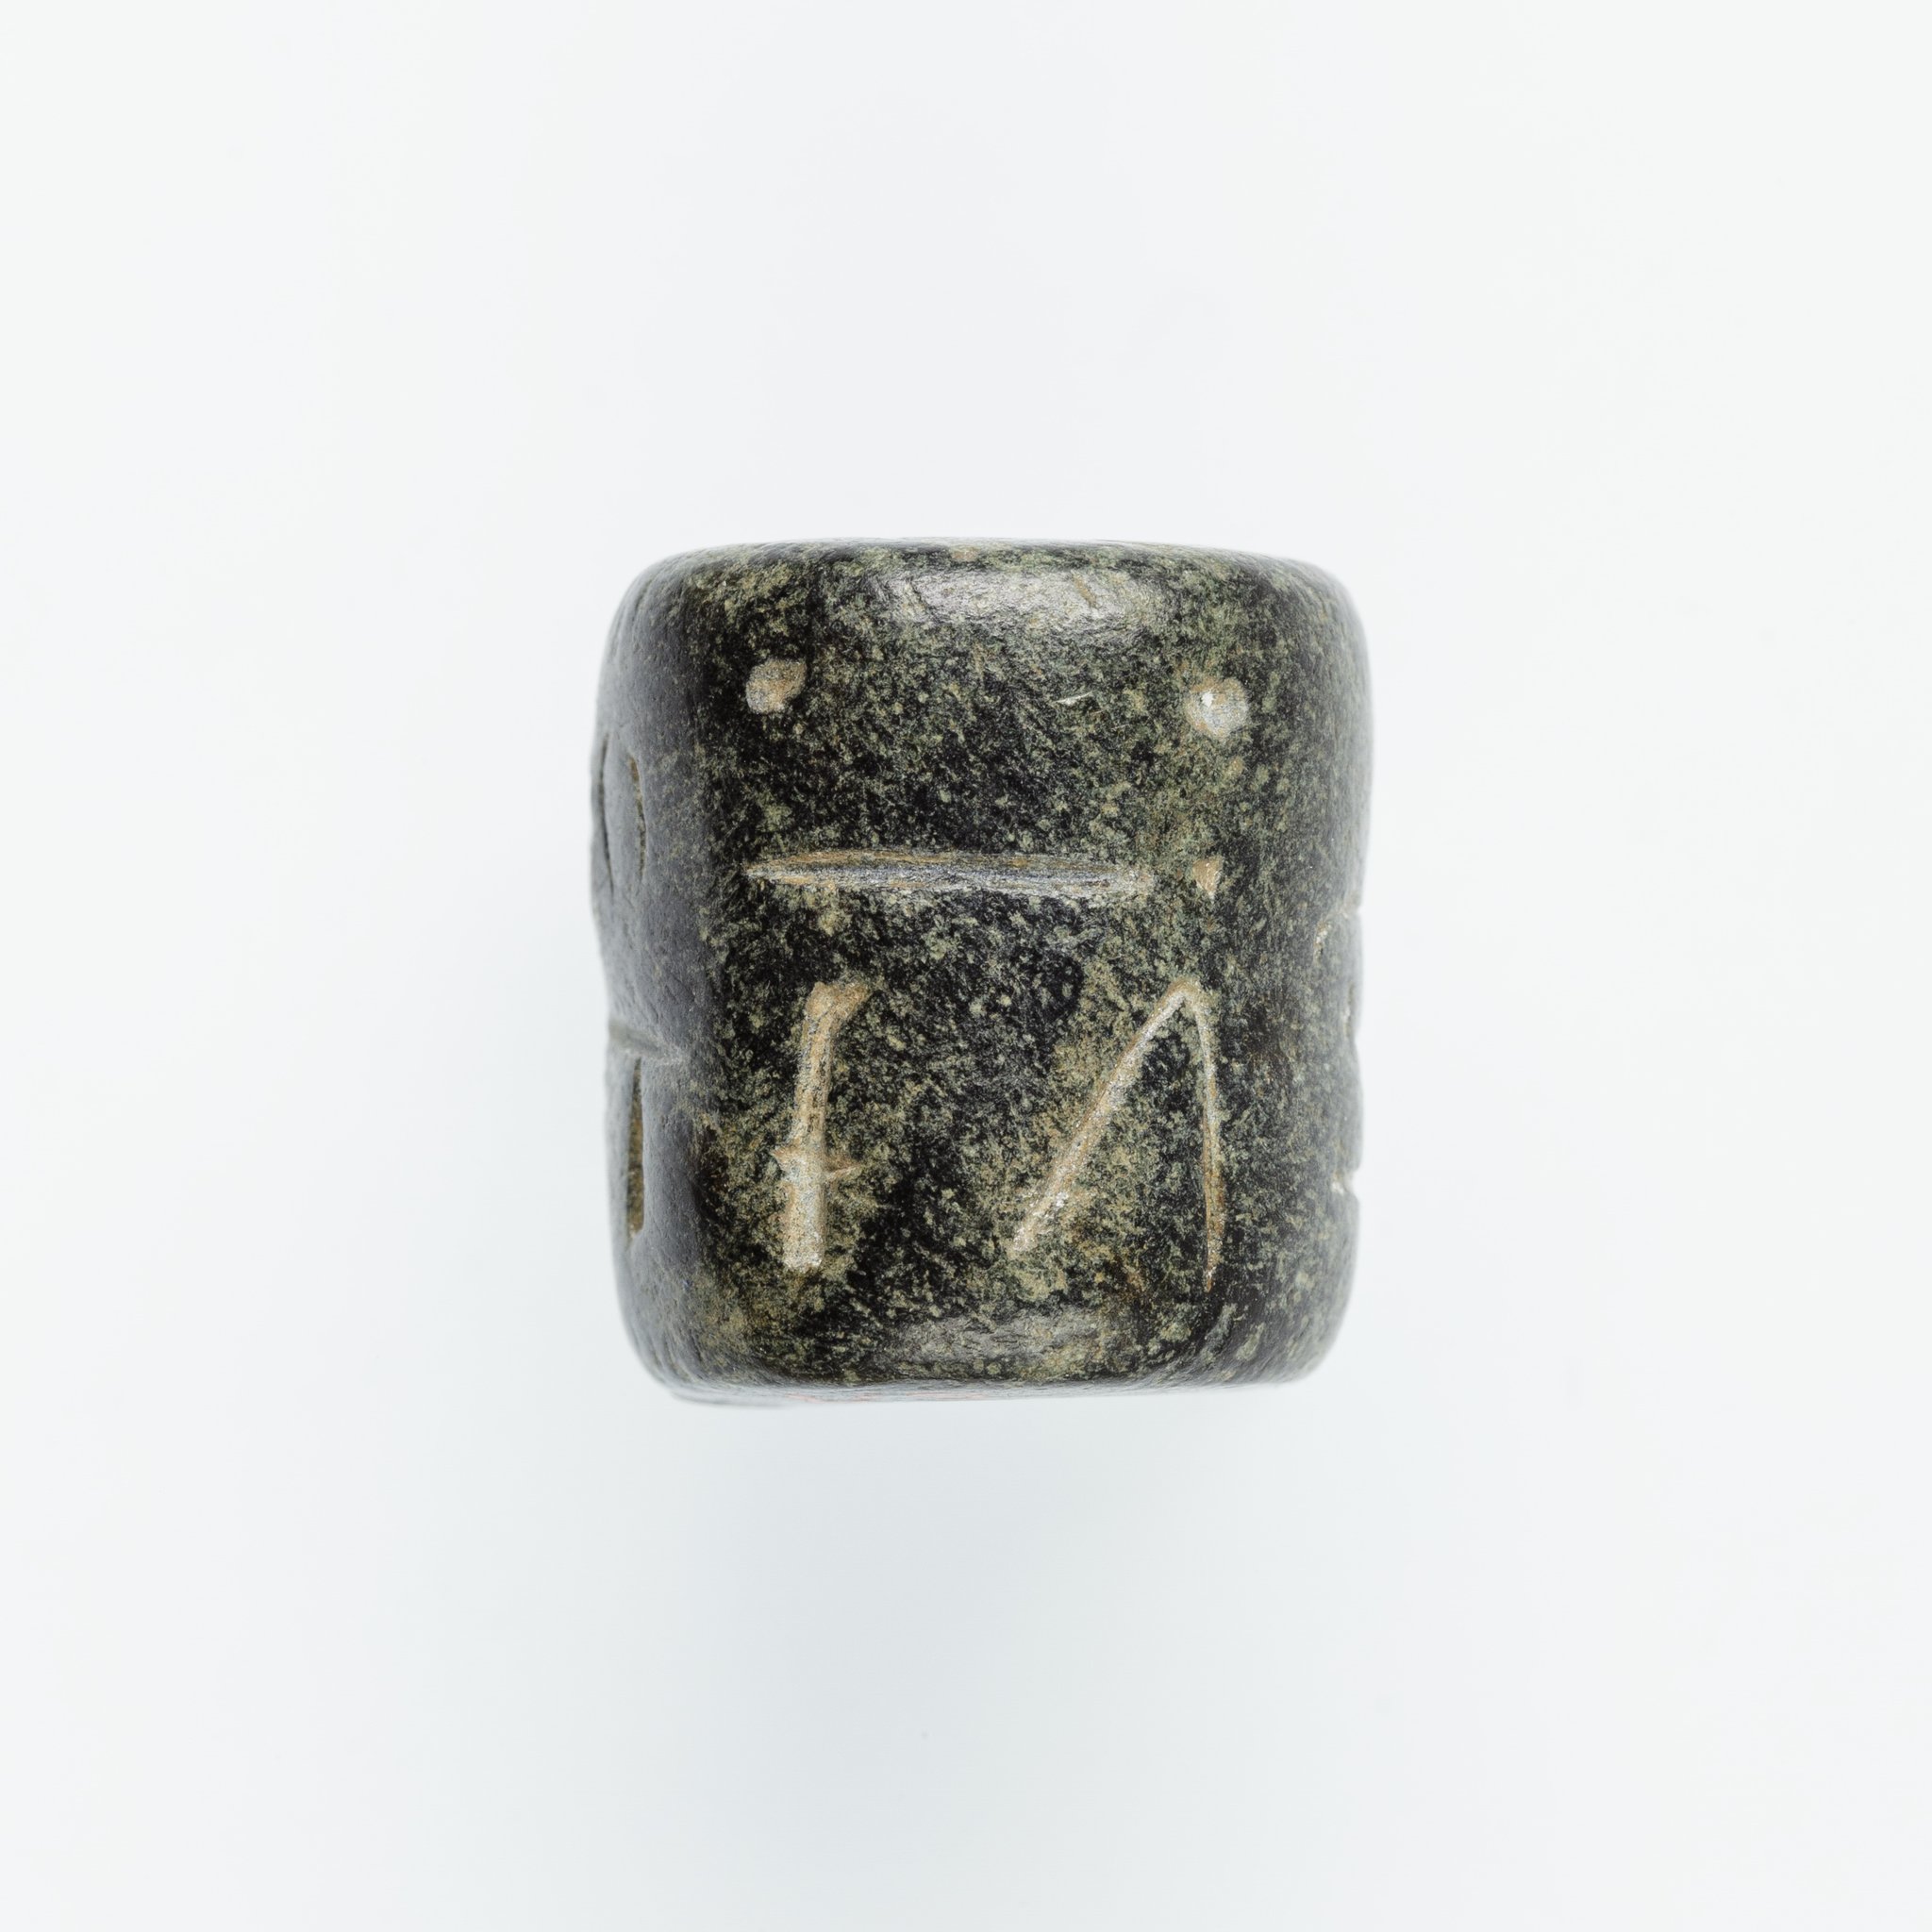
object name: cylinder seal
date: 2960-2649 BCE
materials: stone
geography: egypt